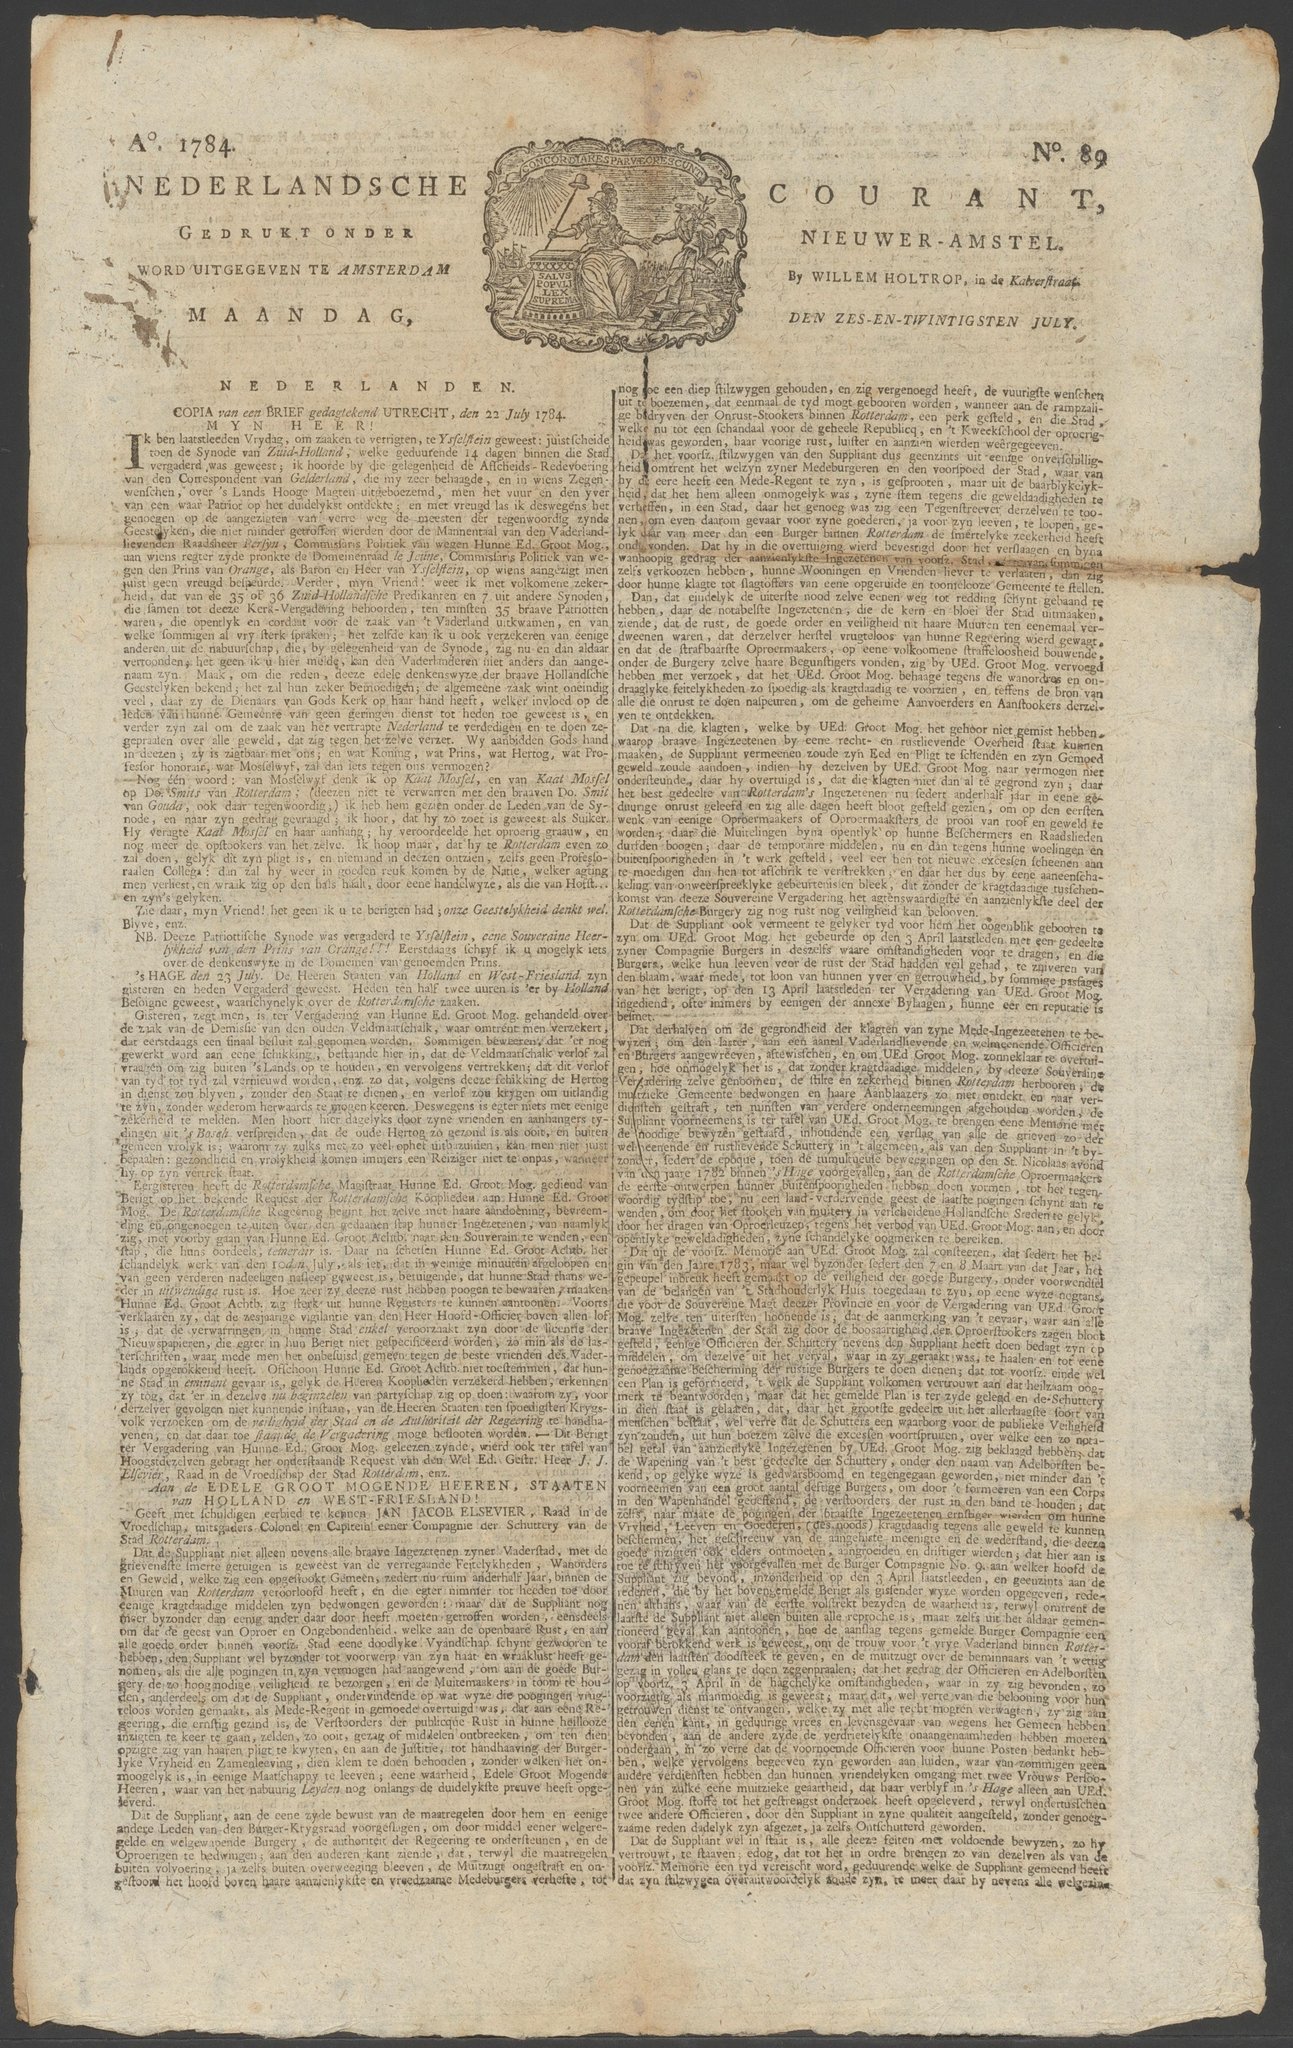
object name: newspaper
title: Nederlandsche Courant, 26 juli 1784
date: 1784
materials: paper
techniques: letterpress printing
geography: amsterdam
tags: newspaper, news-sheet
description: Exemplaar van de krant 'Nederlandsche Courant' van 26 juli 1784. Enkelbladig, beide zijden bedrukt. Bovenaan een vignet met de Vrijheid en Mercurius. Onderwerpsrubrieken binnen de Atlas Zeden en Gewoonten: Regeering, Officieele Nieuwsbladen.